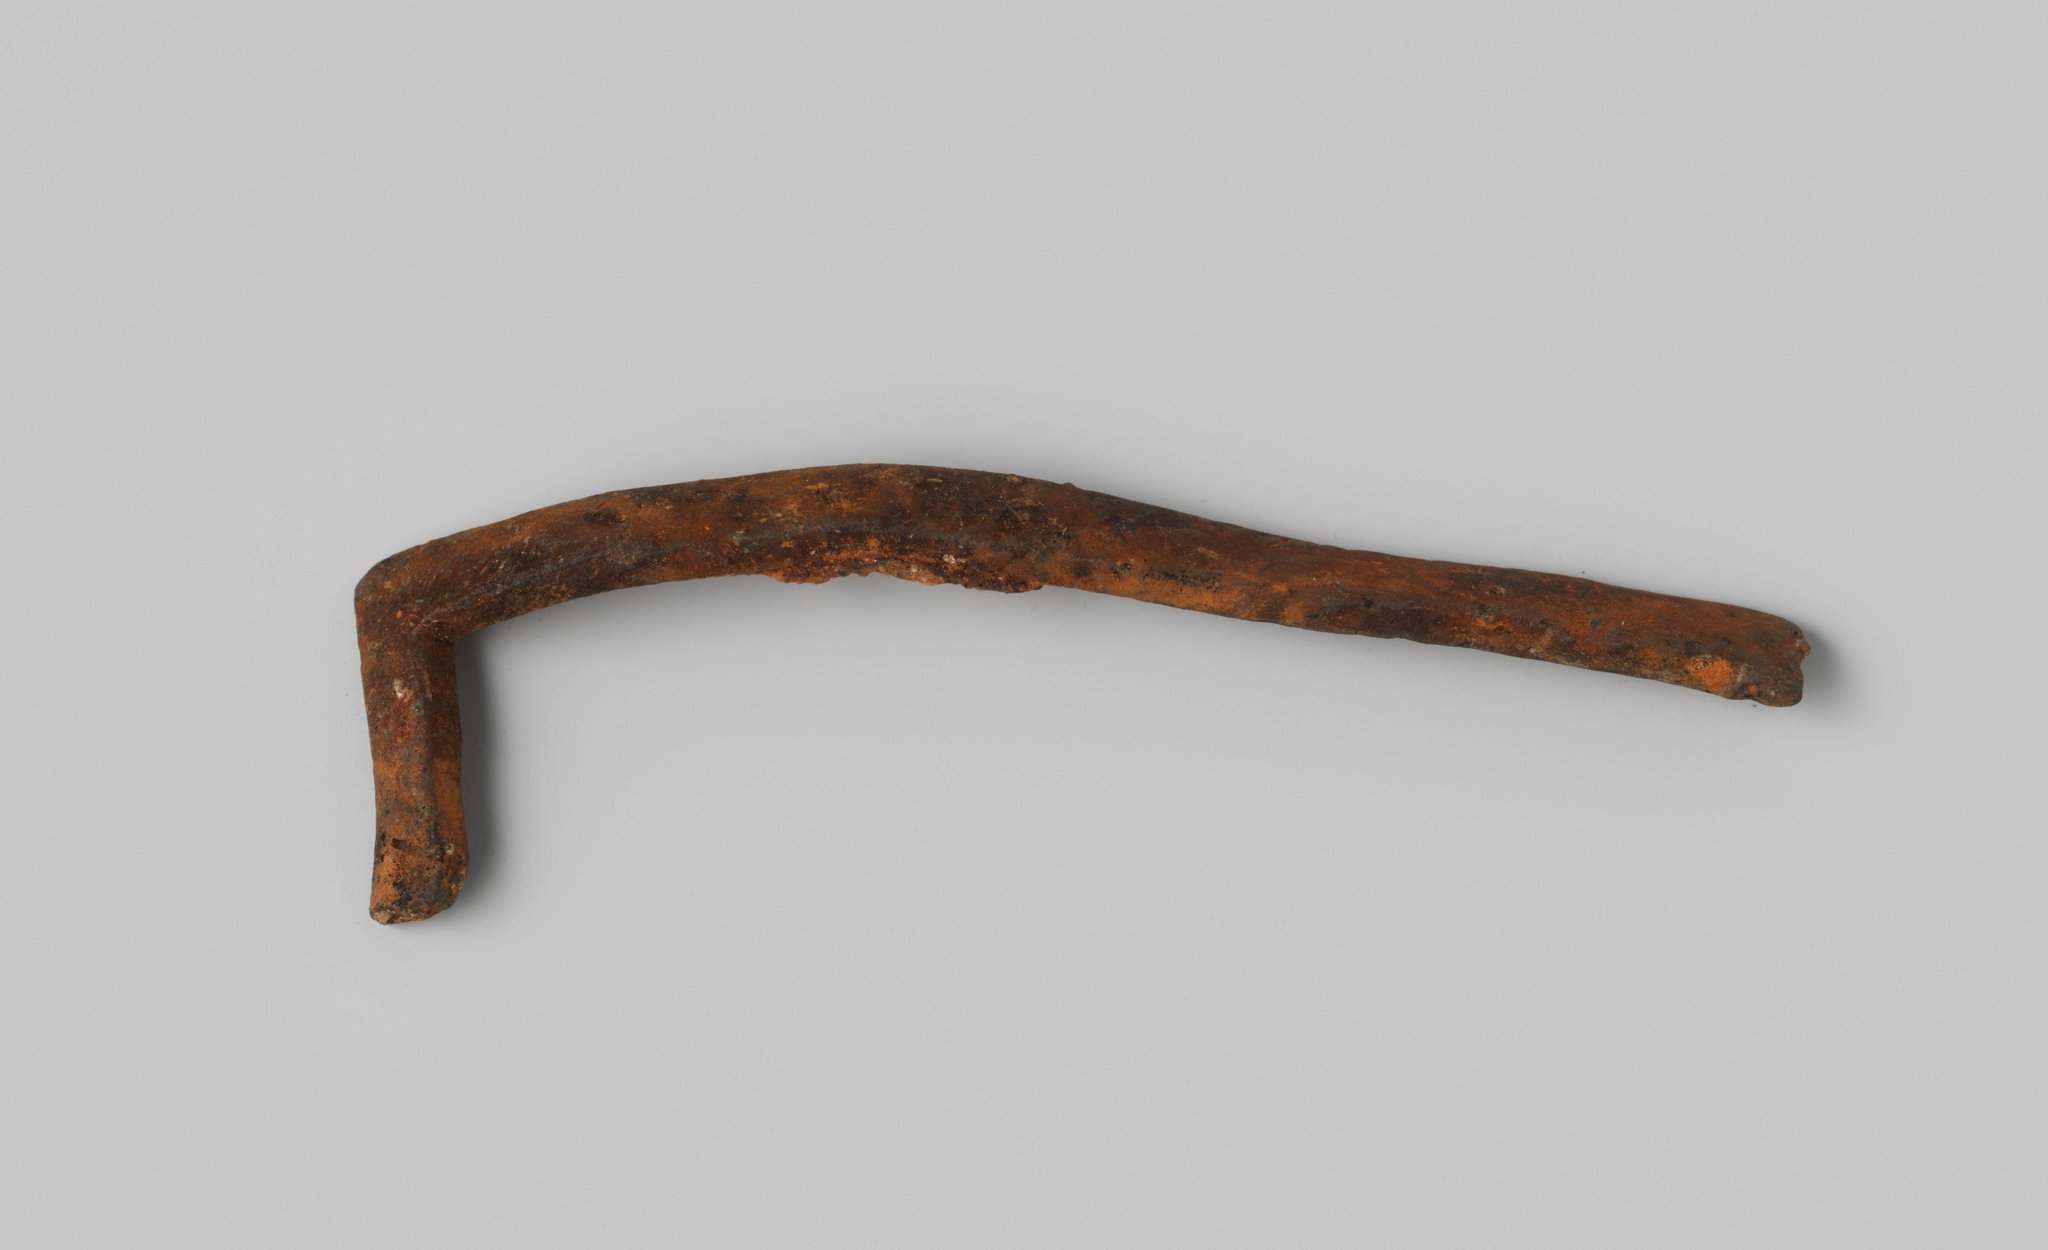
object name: belt buckle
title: Fragment riemgesp uit het wrak van de Oost-Indiëvaarder Hollandia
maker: Anonymous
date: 1700-1743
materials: copper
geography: netherlands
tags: verenigde oostindische compagnie, hollandia (schip), annet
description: Rectangular, fragm of ring, id. NG 1980-27H2852, belt buckle.